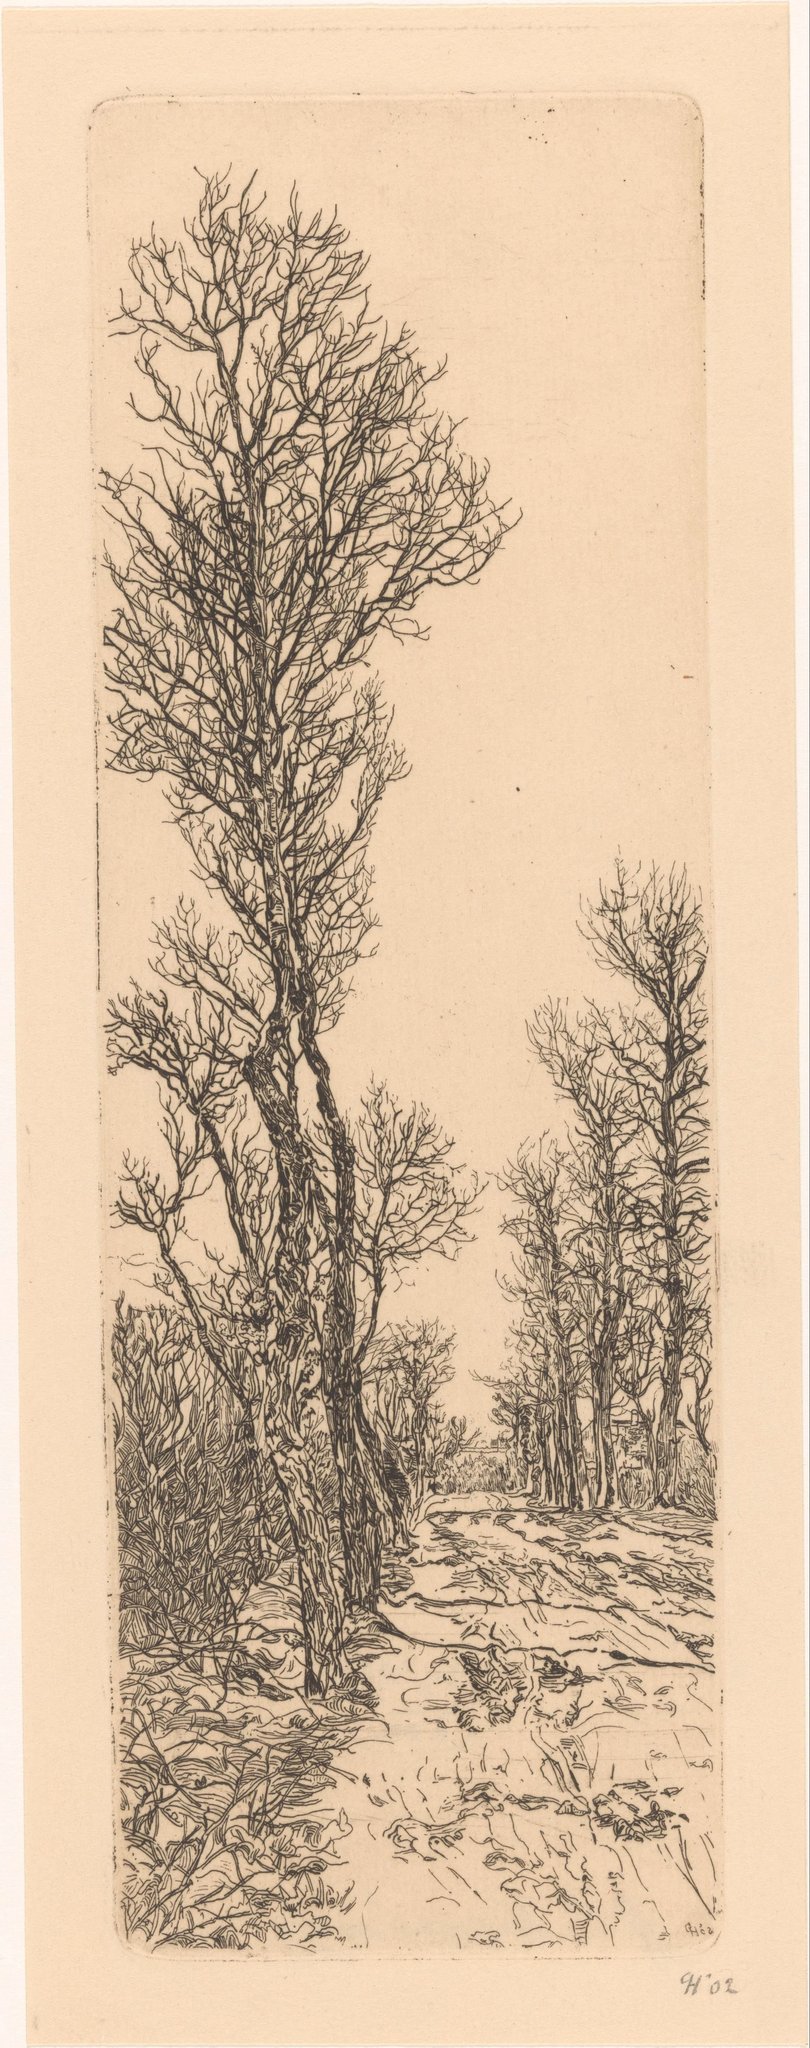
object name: print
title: Besneeuwde landweg met bomen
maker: gerrit haverkamp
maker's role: print maker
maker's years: 1872-1926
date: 1902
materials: paper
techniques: etching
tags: trees, road, path, snow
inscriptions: collector's mark: Lugt 2228